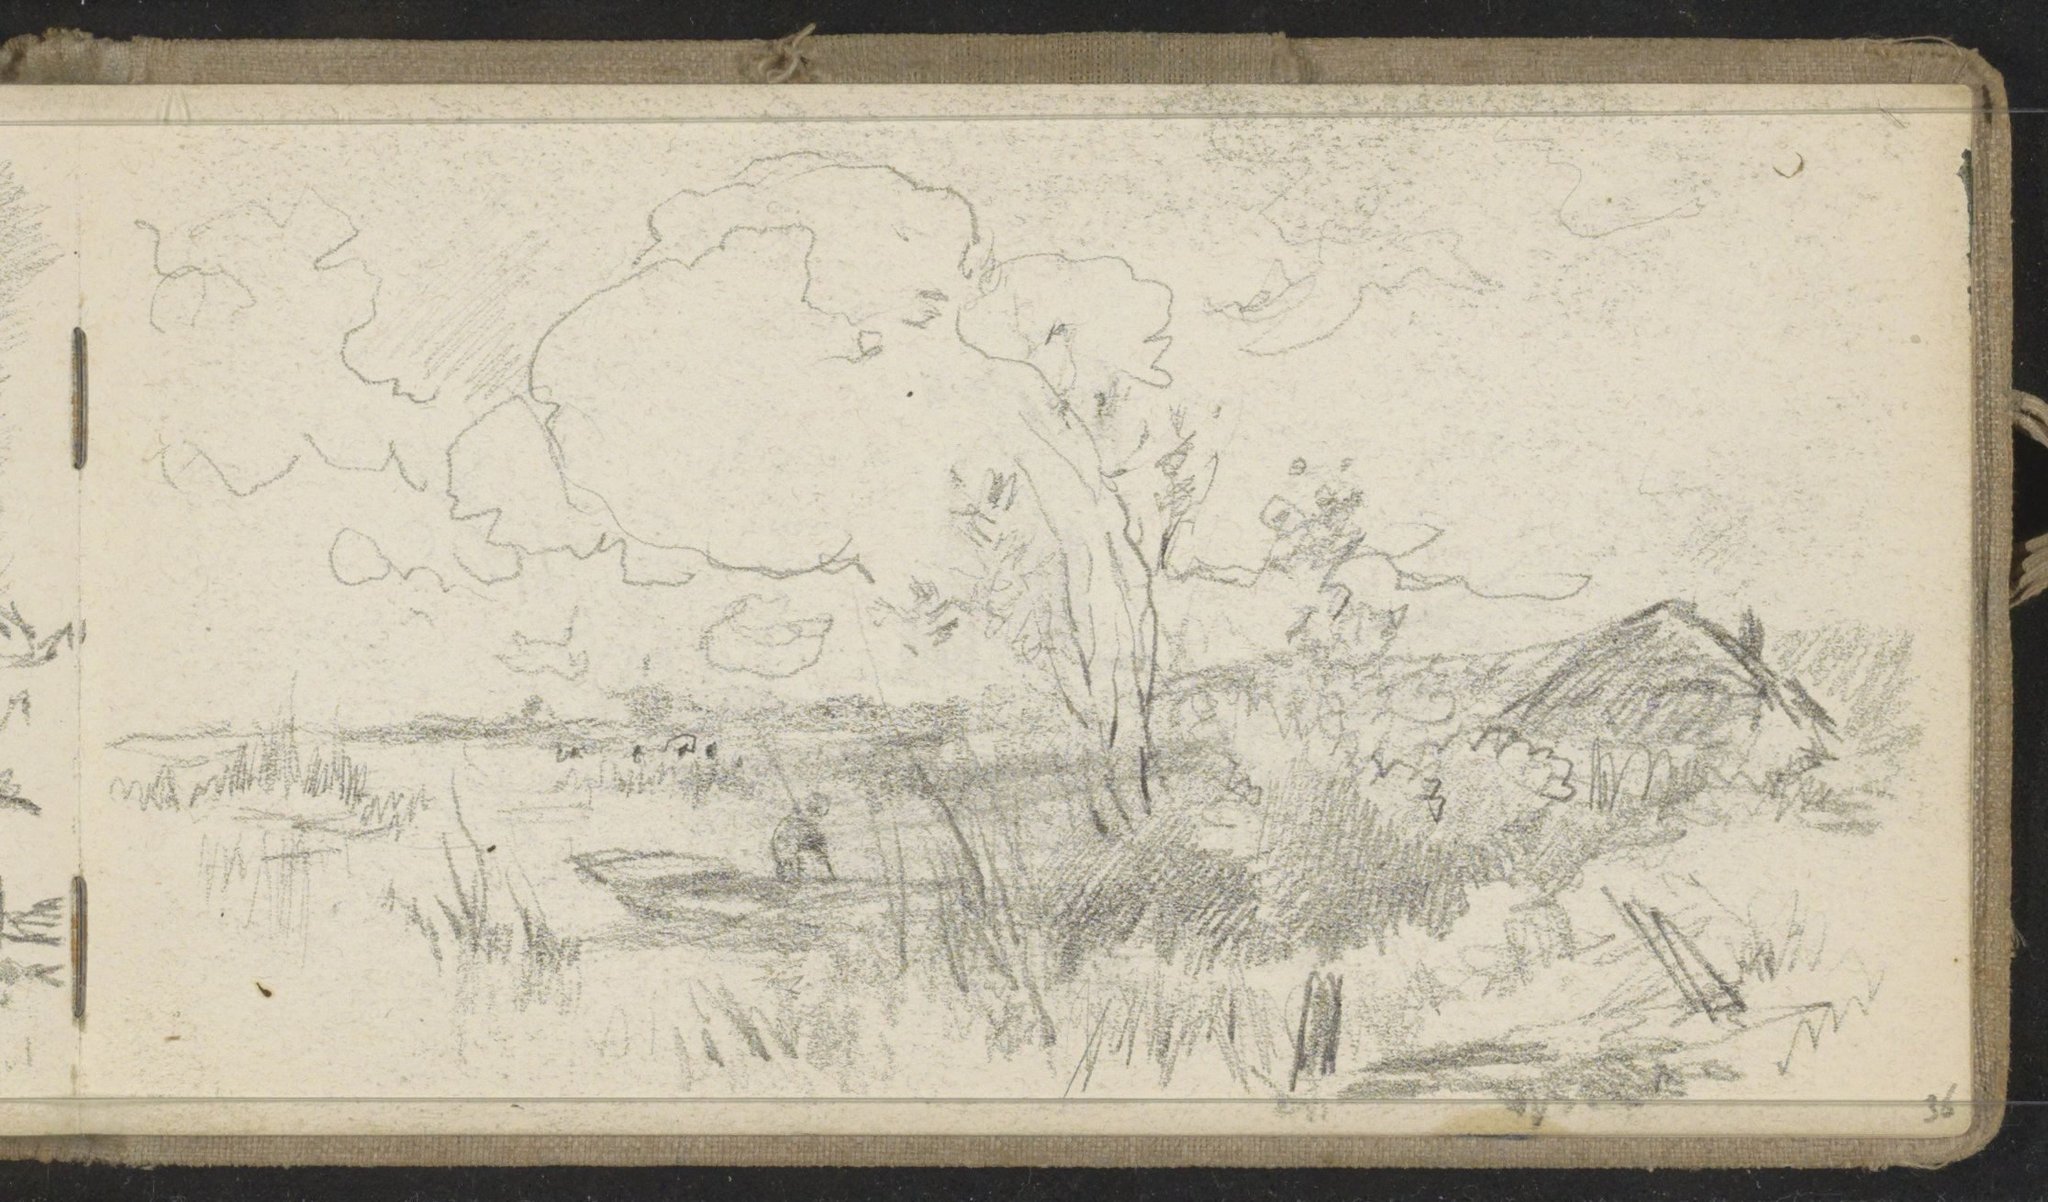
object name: sketchbook leaf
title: Figuur in een roeiboot bij een waterkant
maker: willem cornelis rip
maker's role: draughtsman, painter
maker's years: 1856-1922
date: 1895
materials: paper, pencil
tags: rowing-boat, canoe, etc., landscapes with waters, waterscapes, seascapes (in the temperate zone) (+ landscape with figures, staffage)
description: Blad 36 recto uit een schetsboek met 39 bladen.